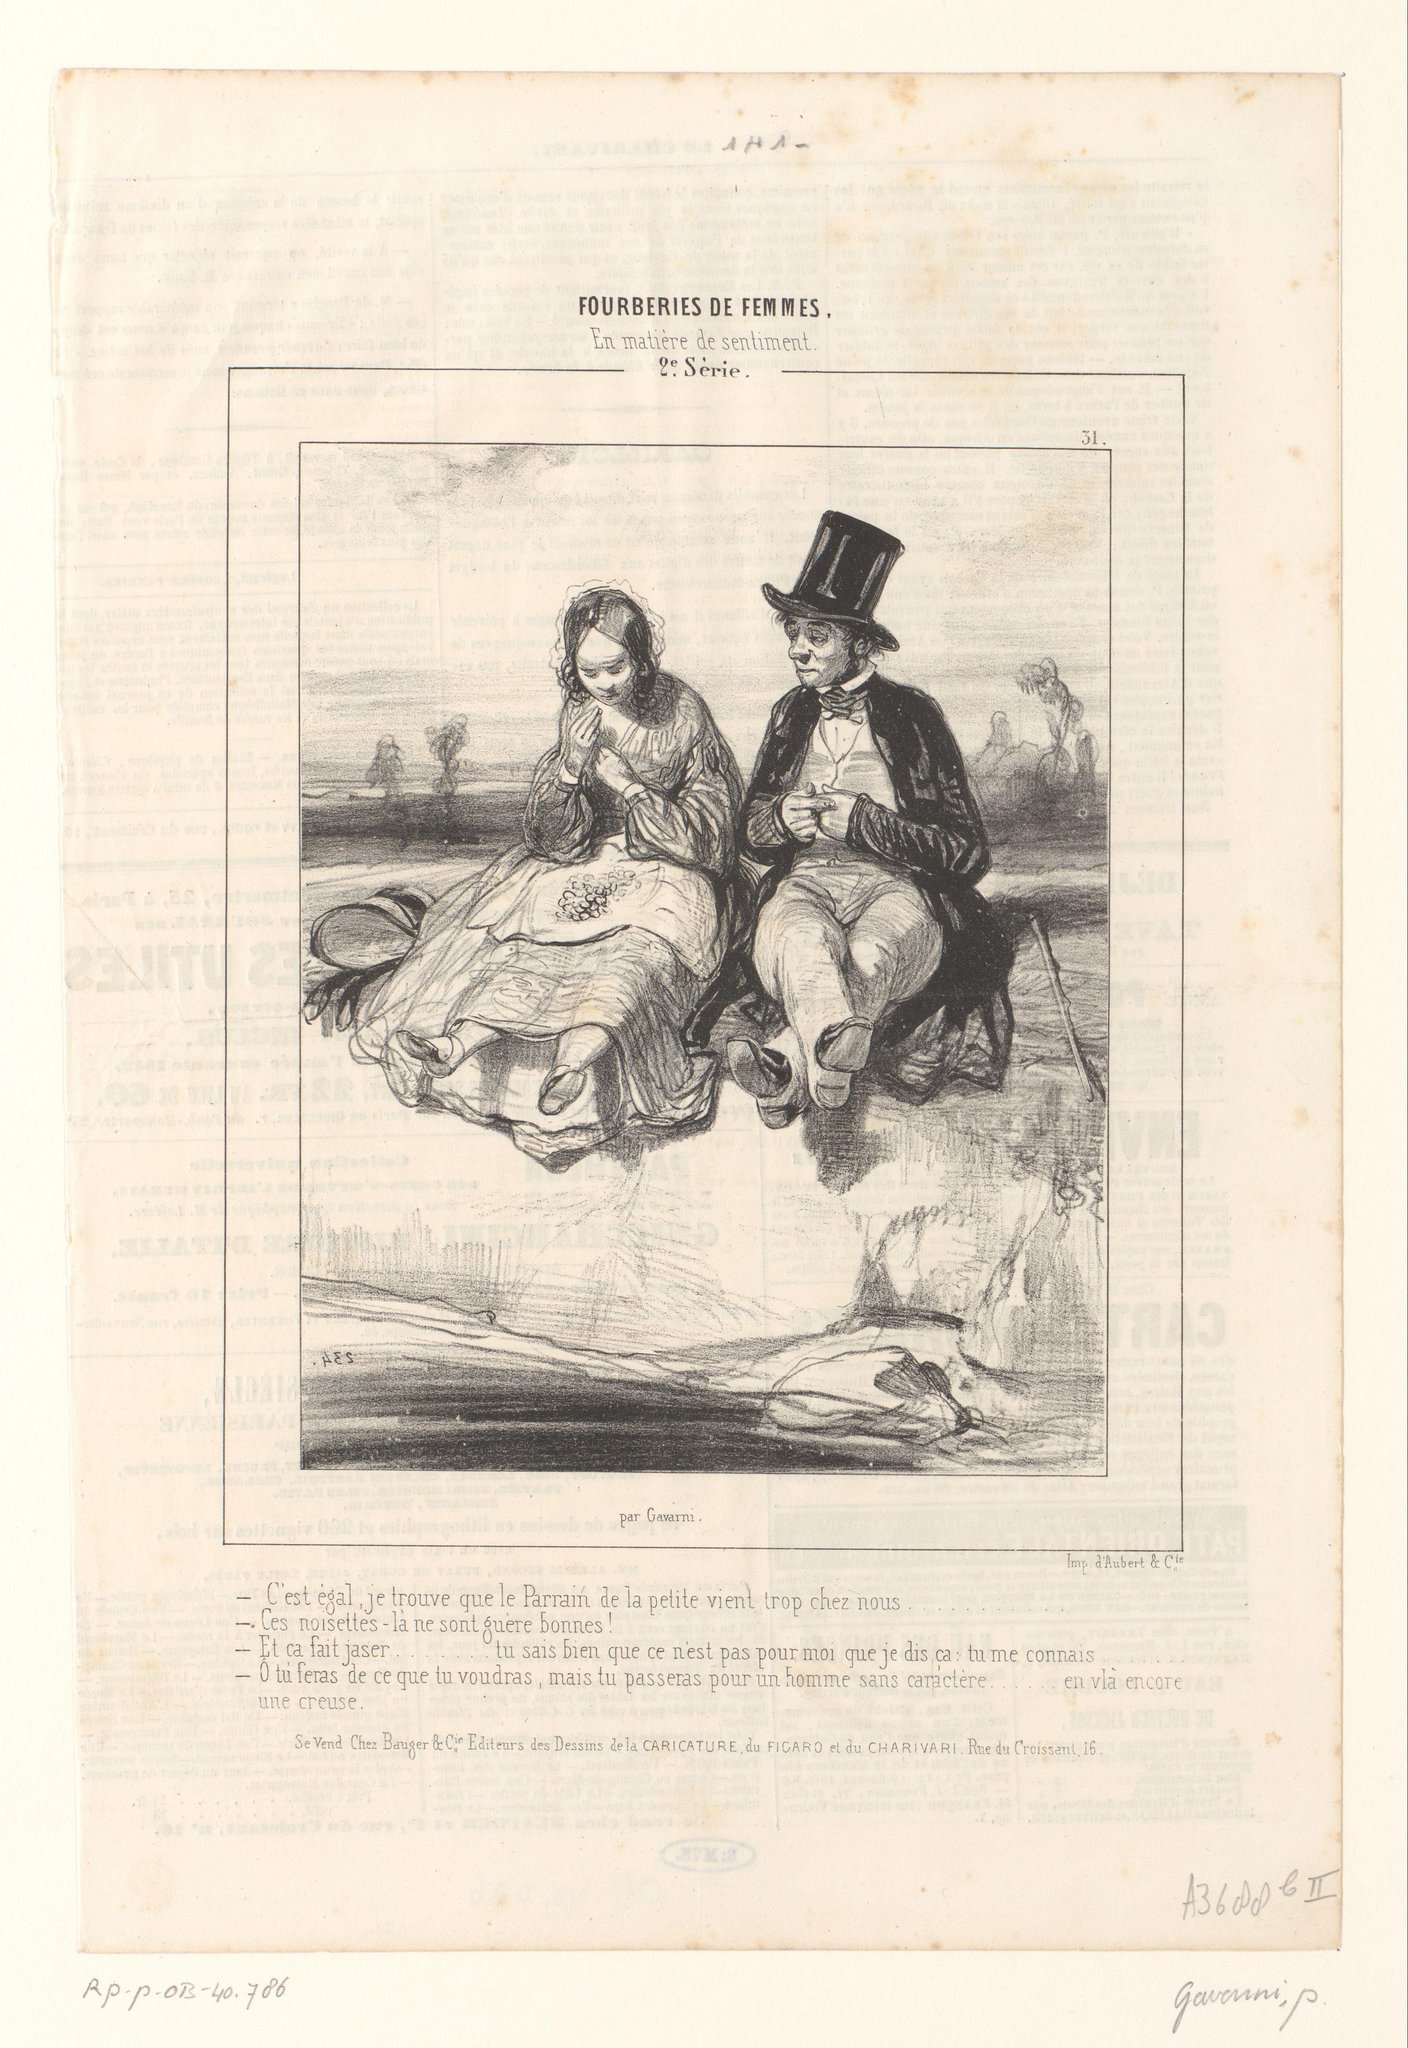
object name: print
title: Man met noten etende vrouw aan de waterkant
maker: paul gavarni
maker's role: draughtsman, print maker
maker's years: 1804-1866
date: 1840-1841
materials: paper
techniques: lithograph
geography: paris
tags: fruits: nuts, satire on marriage, small canal, ditch (+ landscape with figures, staffage)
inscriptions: collector's mark: Lugt 2228a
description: Prent gebruikt voor: Le Charivari, 23 juni 1841.